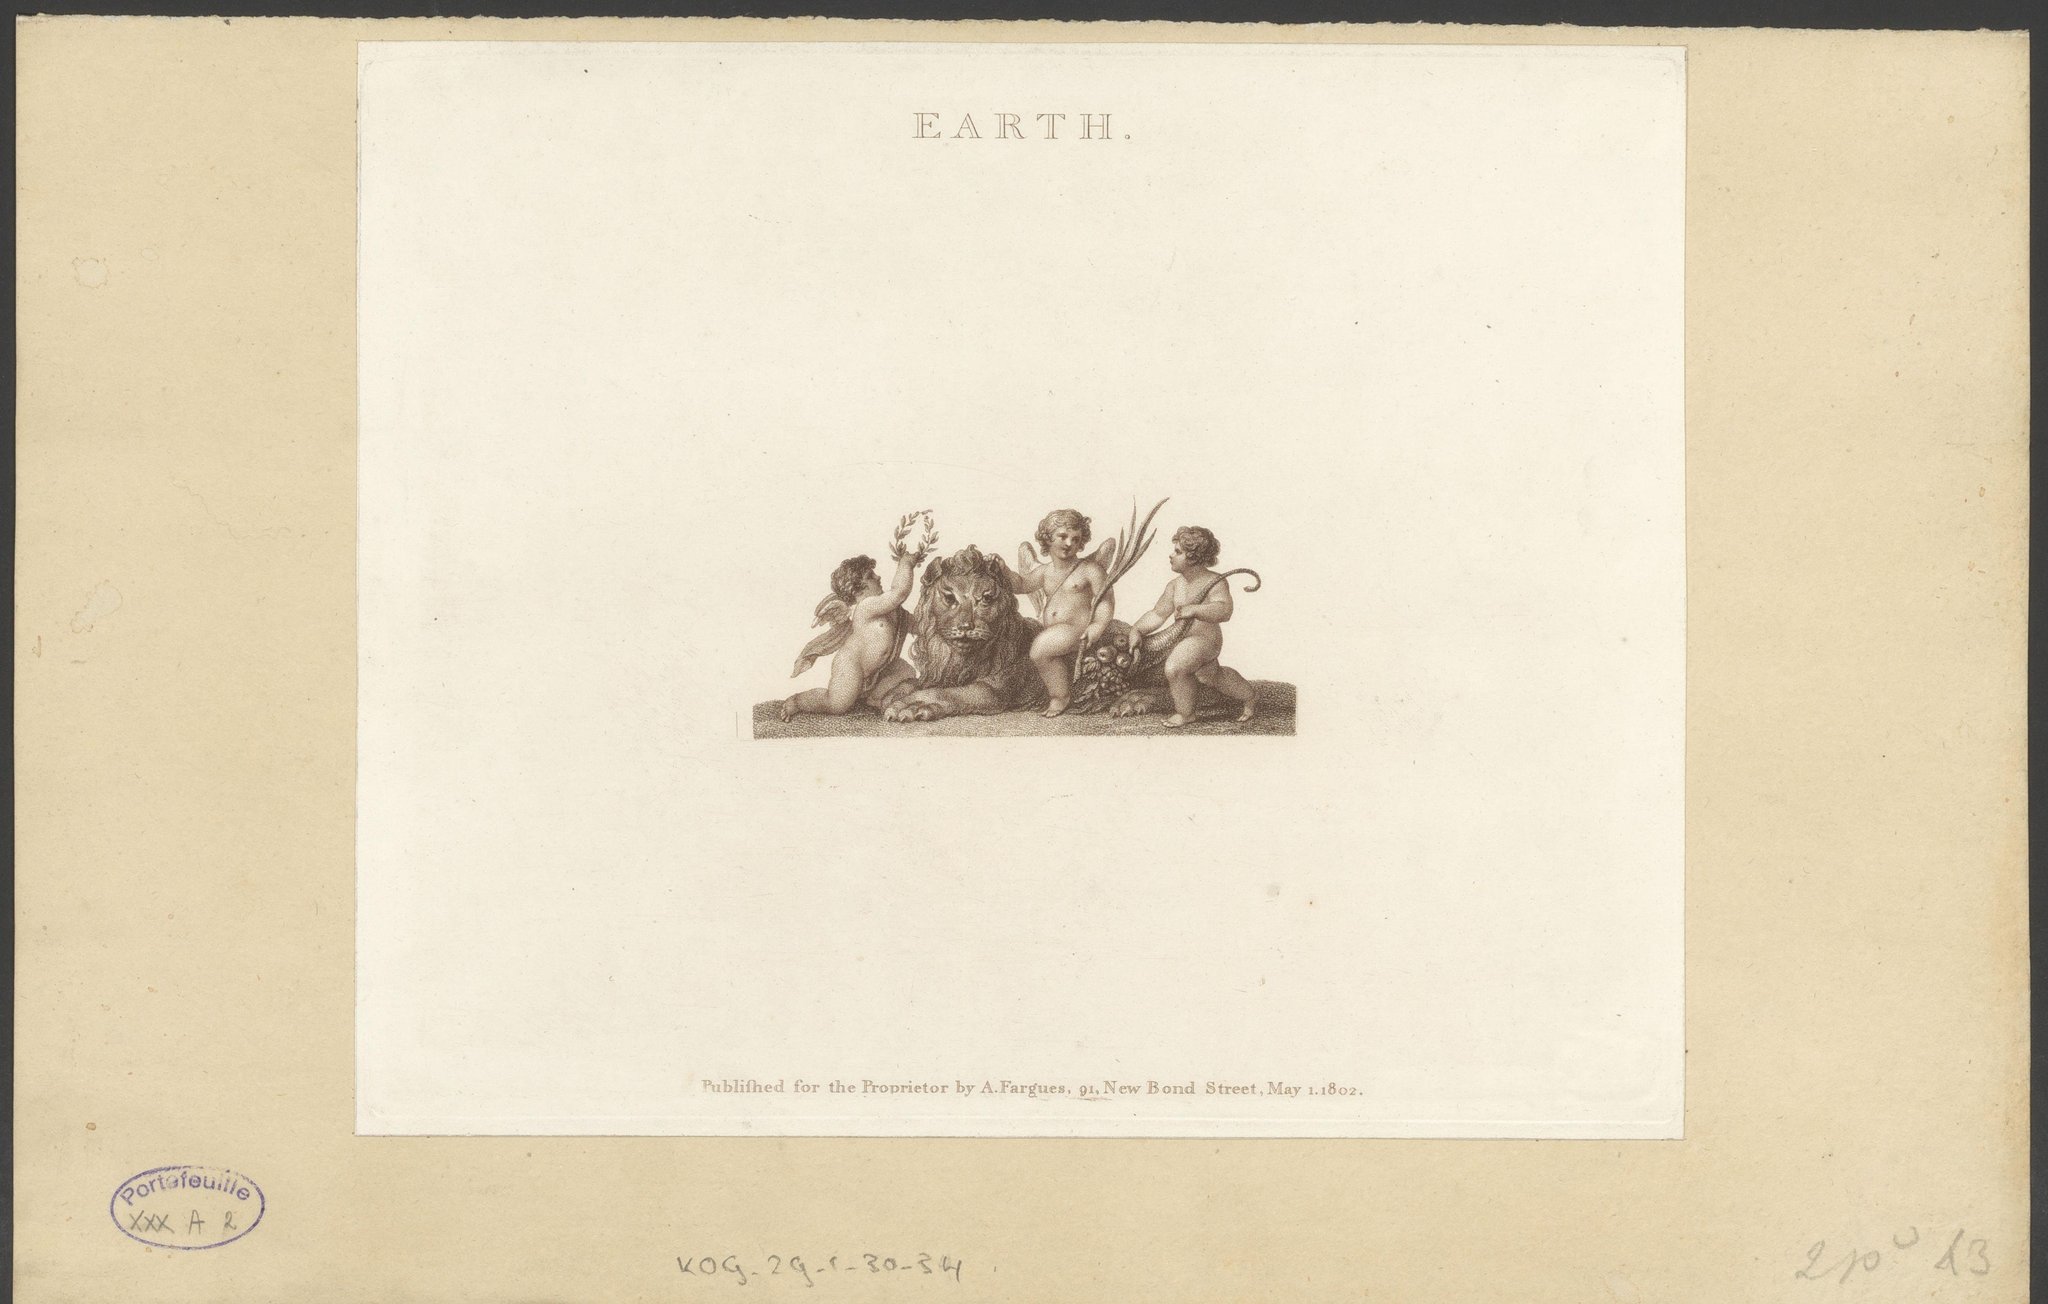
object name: print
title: Drie putti beelden het element Aarde uit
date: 1802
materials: paper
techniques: etching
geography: amsterdam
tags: earth (one of the four elements), beasts of prey, predatory animals: lion, cupids: 'amores', 'amoretti', 'putti'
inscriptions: stamp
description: Drie putti beelden het element Aarde uit. Links een putto met een lauwerkrans koraal in zijn hand. In het midden een putto op een leeuw met een palmtak in zijn hand en rechts nog een putto met een hoorn des overvloeds. Onderwerpsrubrieken binnen de Atlas Zeden en Gewoonten: Zeden en Gewoonten in engeren zin. Volksleven. Zinnebeeldige voorstellingen uit het volkleven op serieprenten. Elementen.